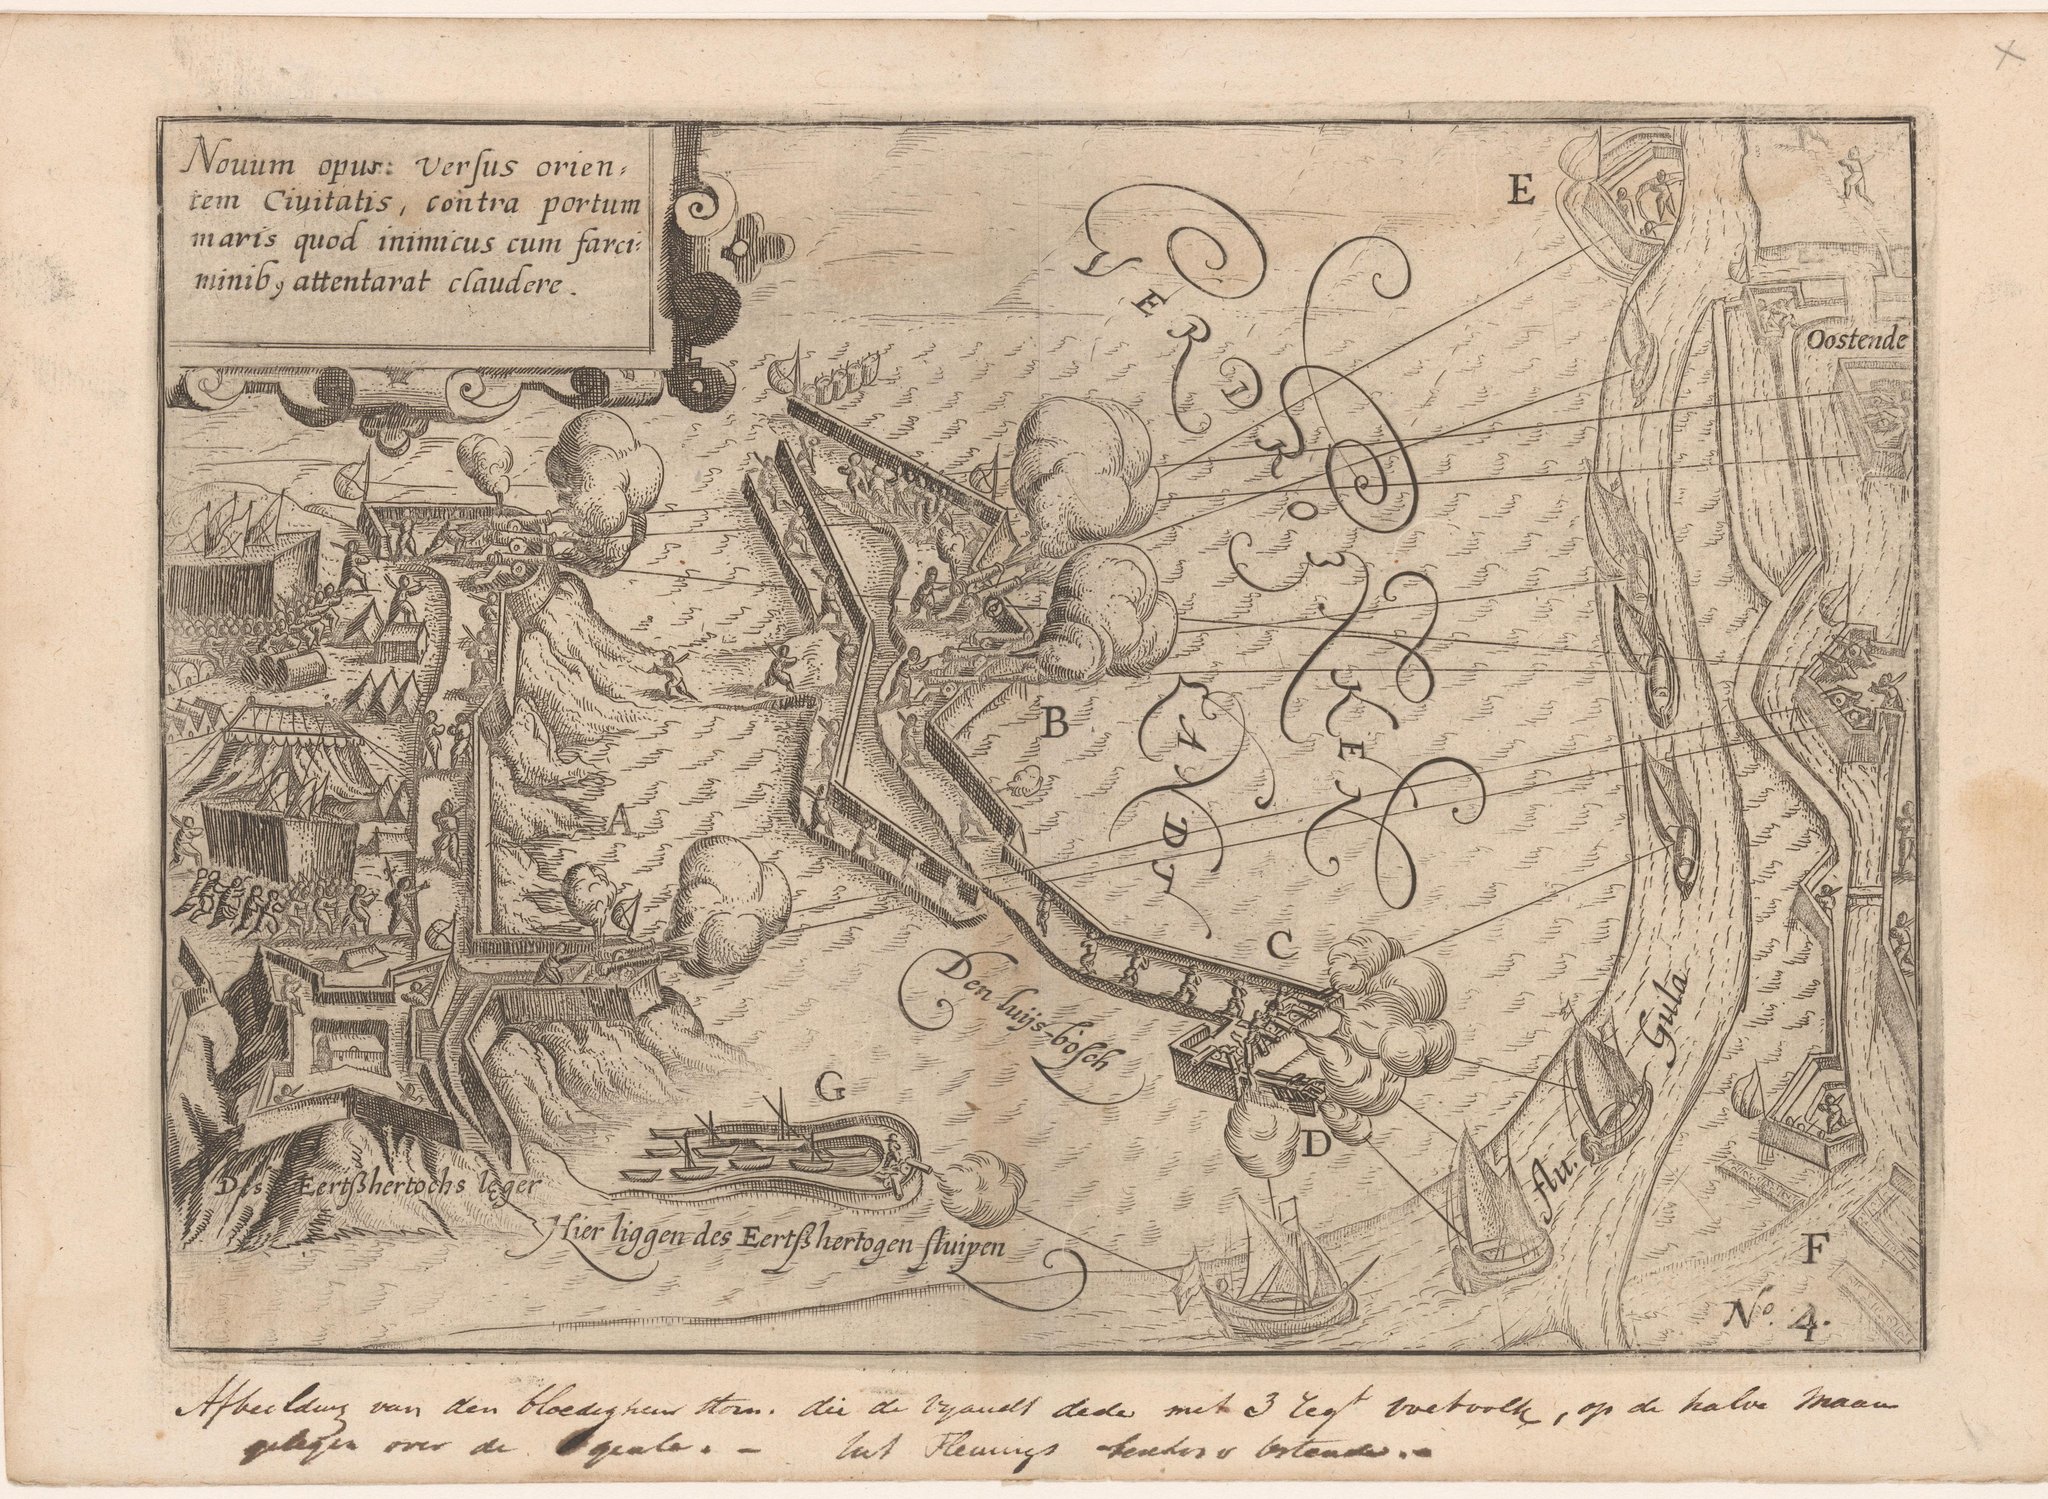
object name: print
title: Beleg van Oostende: beschieting van de schepen die de stad bevoorraden, 1603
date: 1604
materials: paper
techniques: etching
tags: siege, position war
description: Eerdere staat van prent ook gebruikt in contemporaine journalen van het beleg van Oostende uit 1604 (exemplaren in de collectie van de Rijksmuseum Research Library (326 F 10 en 326 F 11). En in: Haestens, Hendrick van. De Bloedige ende strenge Belegeringhe Der Stadt Oostende in Vlaenderen, Leiden: Hendrick van Haestens, 1613. Huidige staat van prent ook gebruikt in: Haestens, Hendrick van. La nouvelle Troye ou memorable histoire du siege d’Ostende. Leiden: Hendrick van Haestens, 1615.